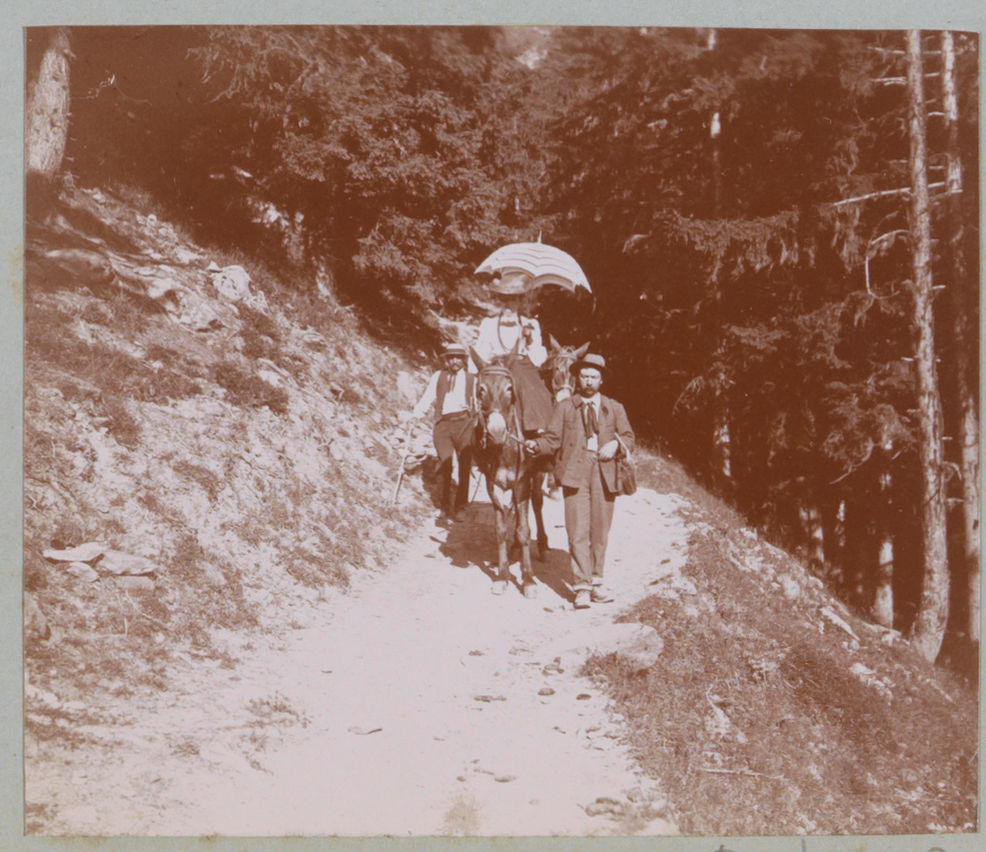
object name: photograph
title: Vrouw op een ezel en twee mannen op een bergpad in de Alpen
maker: Anonymous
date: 1905-1910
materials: paper, photographic support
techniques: gelatin silver print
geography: alps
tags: walking, hiking (recreation), ass, donkey, road, path, colonial government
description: Onderdeel van Fotoalbum van een Franse amateurfotograaf met bezienswaardigheden in Frankrijk, Zwitserland en Italië.